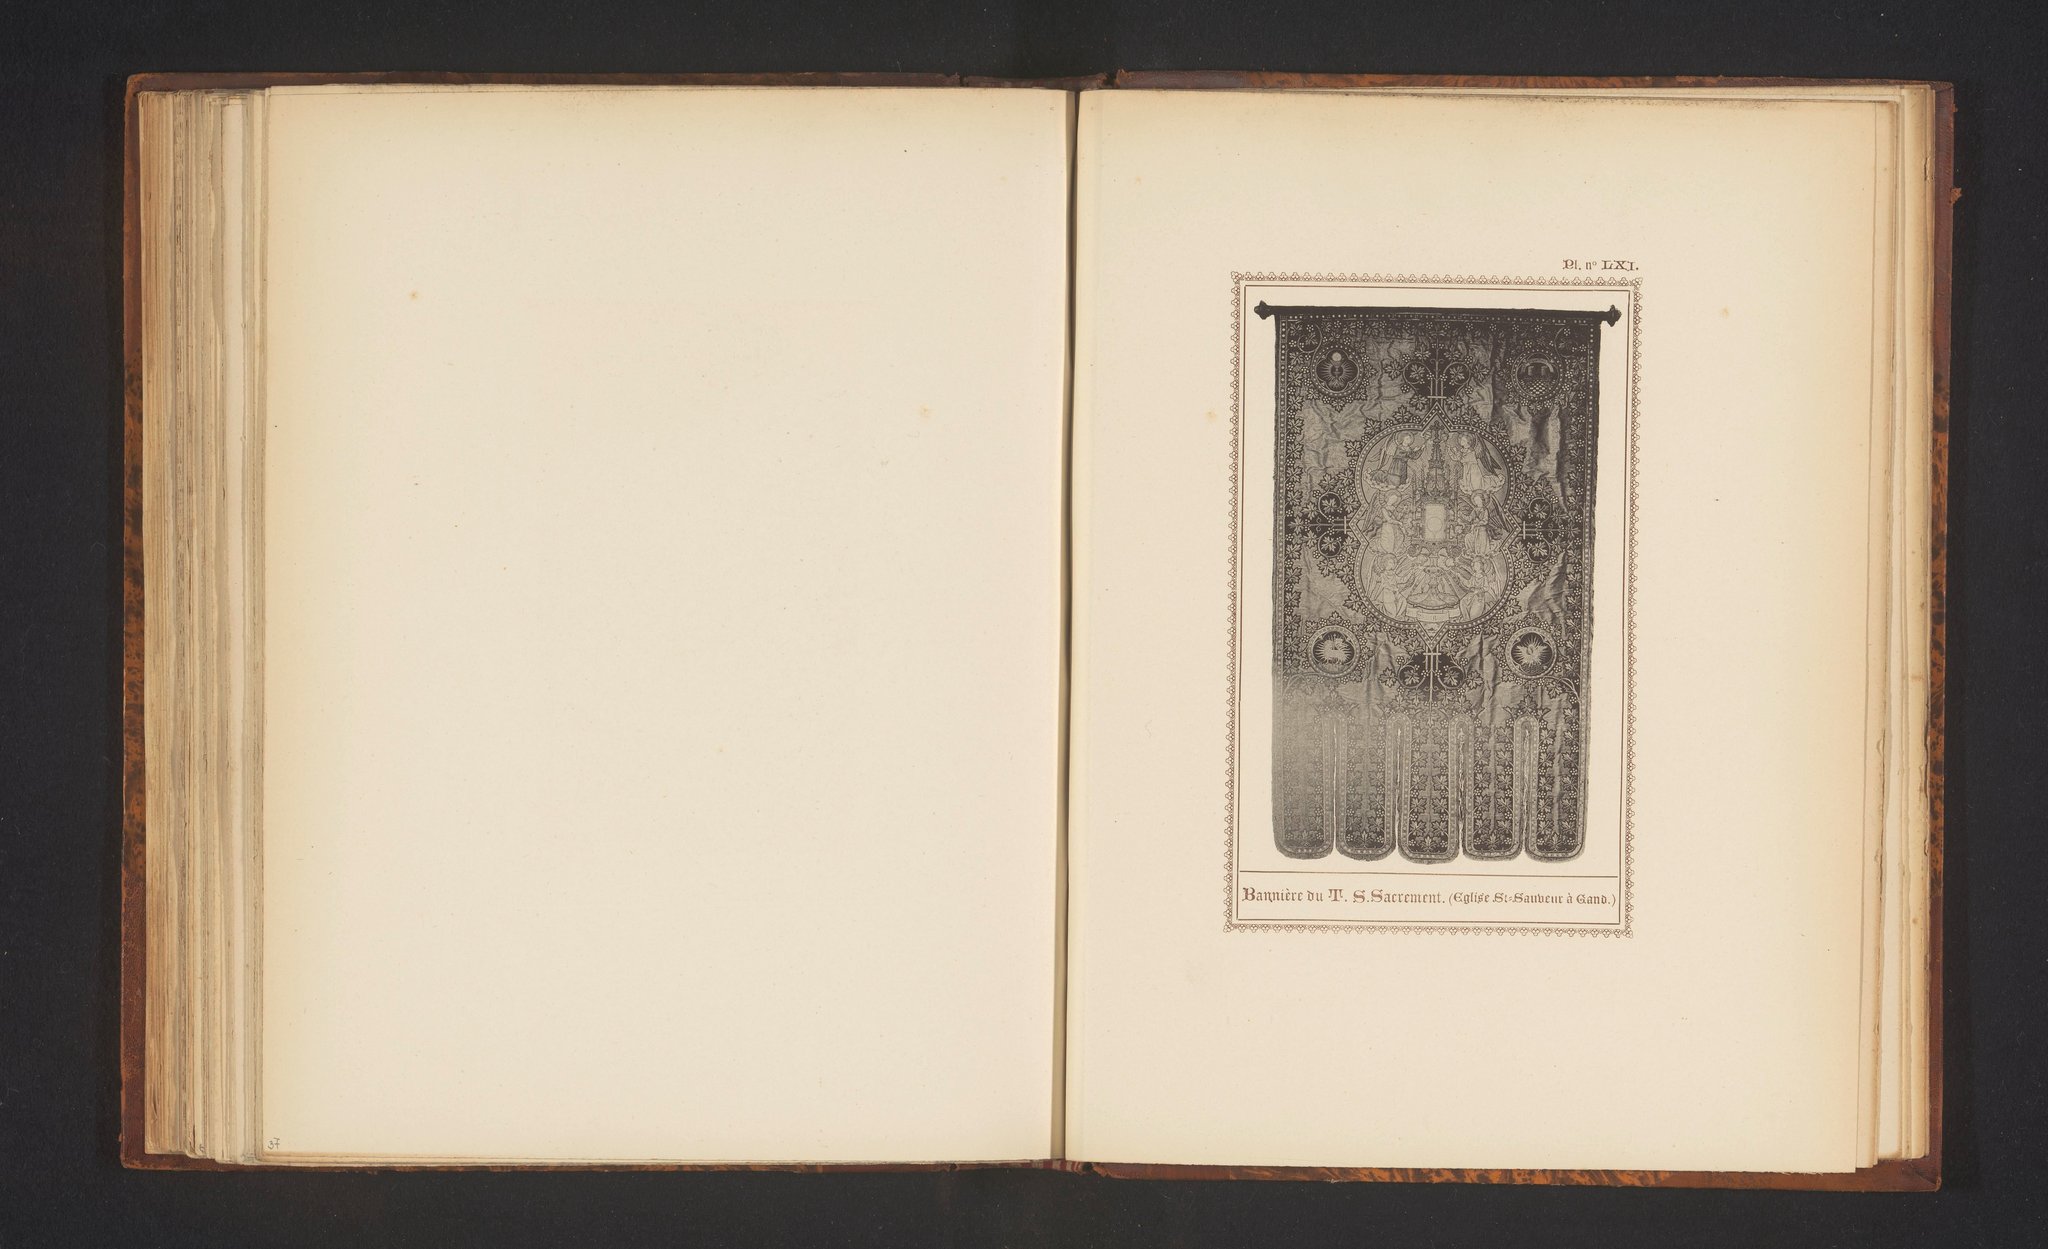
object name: photomechanical print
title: Bannière du T. S. Sacrement. (Eglise St-Sauveur à Gand.)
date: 1891-1896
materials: paper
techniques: photograph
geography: ghent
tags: liturgical vestments, canonicals, ghent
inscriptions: number: ‘Pl. no LXI.’